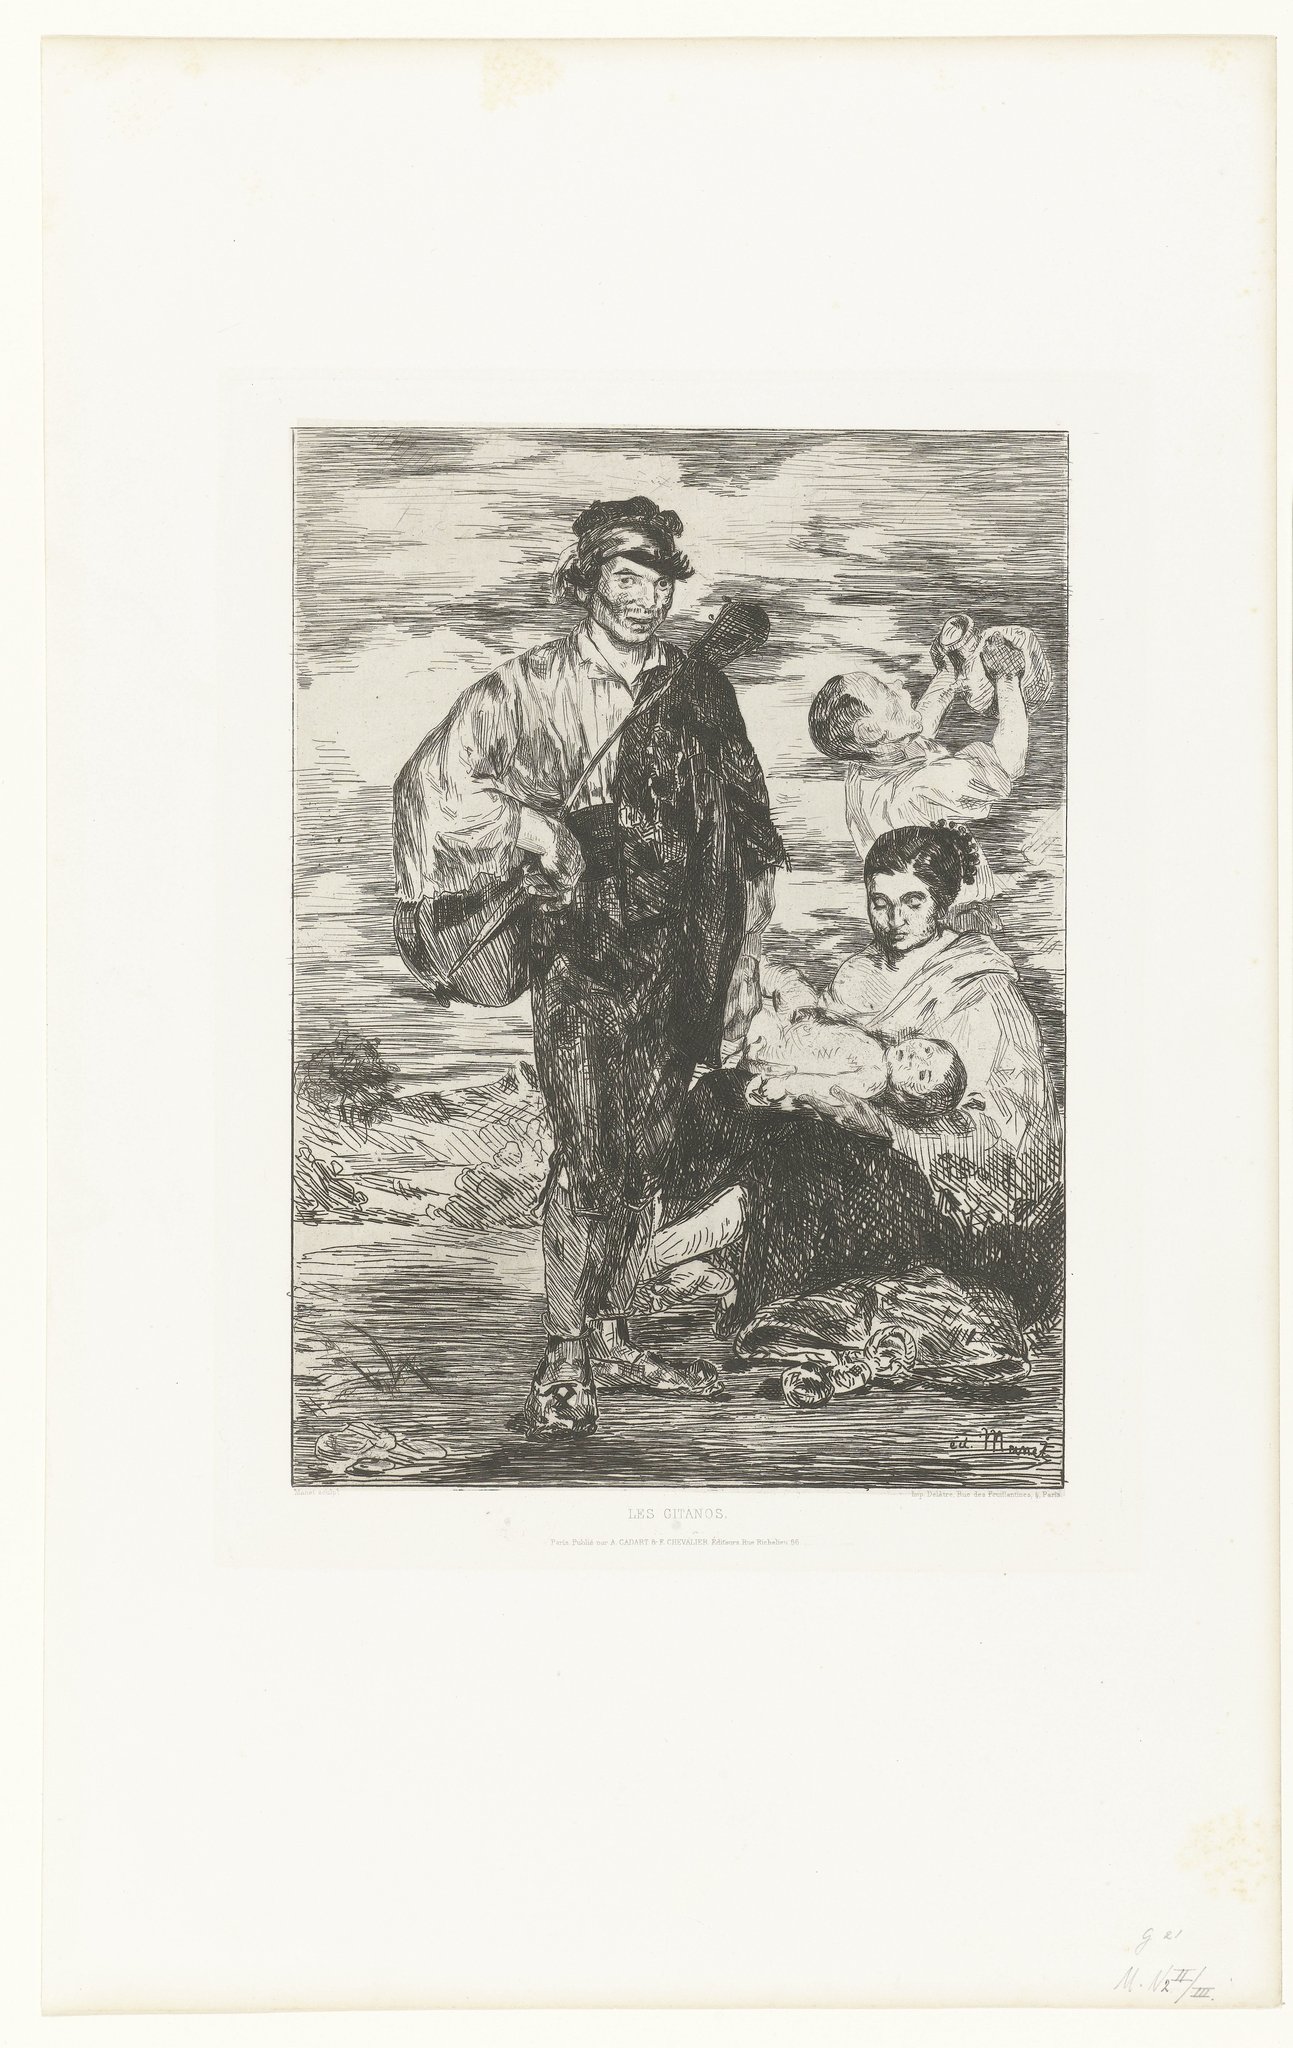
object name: print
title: Zigeunerfamilie met man en vrouw met kind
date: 1862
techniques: printmaking, etching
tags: wandering communities: romani or roma, mother and baby or young child, one person with musical instrument, not playing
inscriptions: collector's mark: Lugt 2233, collector's mark: Lugt 2760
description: Een zigeunerman staat met een gitaar op zijn rug bij een vrouw met een kind op haar schoot. Achter haar drinkt een man uit een kruik.